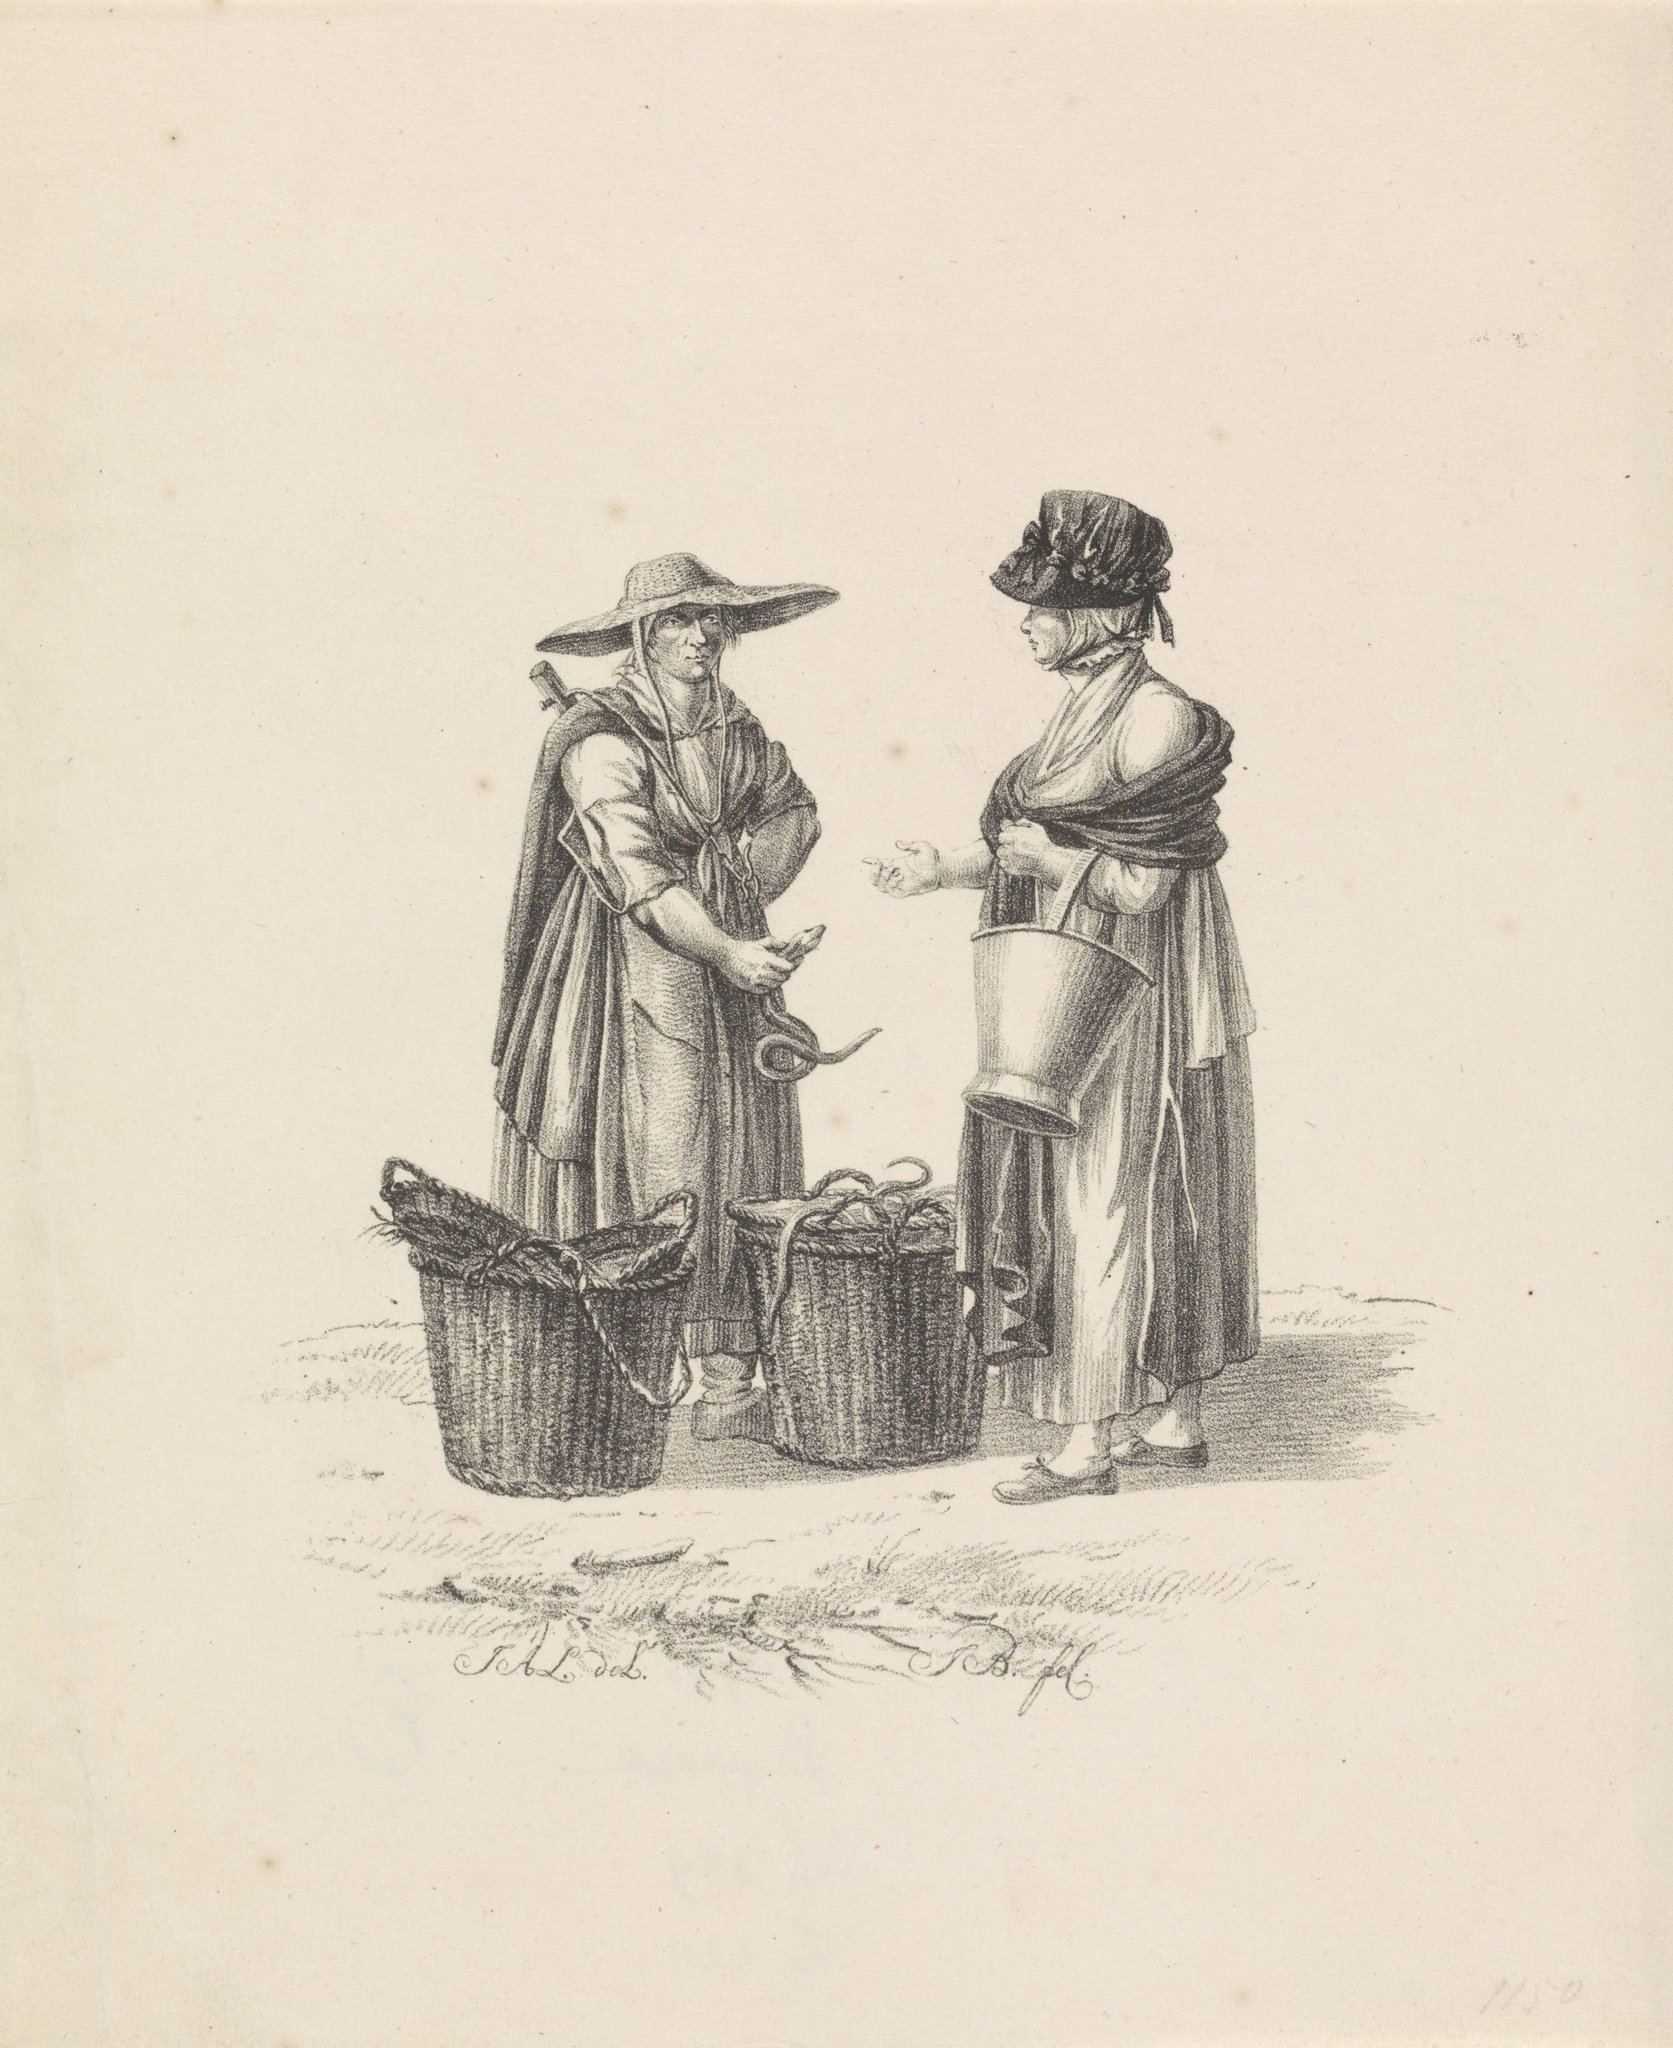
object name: print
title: Palingverkoopster met klant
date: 1820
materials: paper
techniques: lithograph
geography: netherlands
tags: buying and selling, eels: eel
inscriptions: collector's mark: Lugt 2228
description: Een palingverkoopster staat achter twee manden met palingen. In haar rechterhand heeft zij een paling vast. De vrouw tegenover haar draagt een mand aan haar linkerarm en strekt haar rechterhand uit naar de paling.